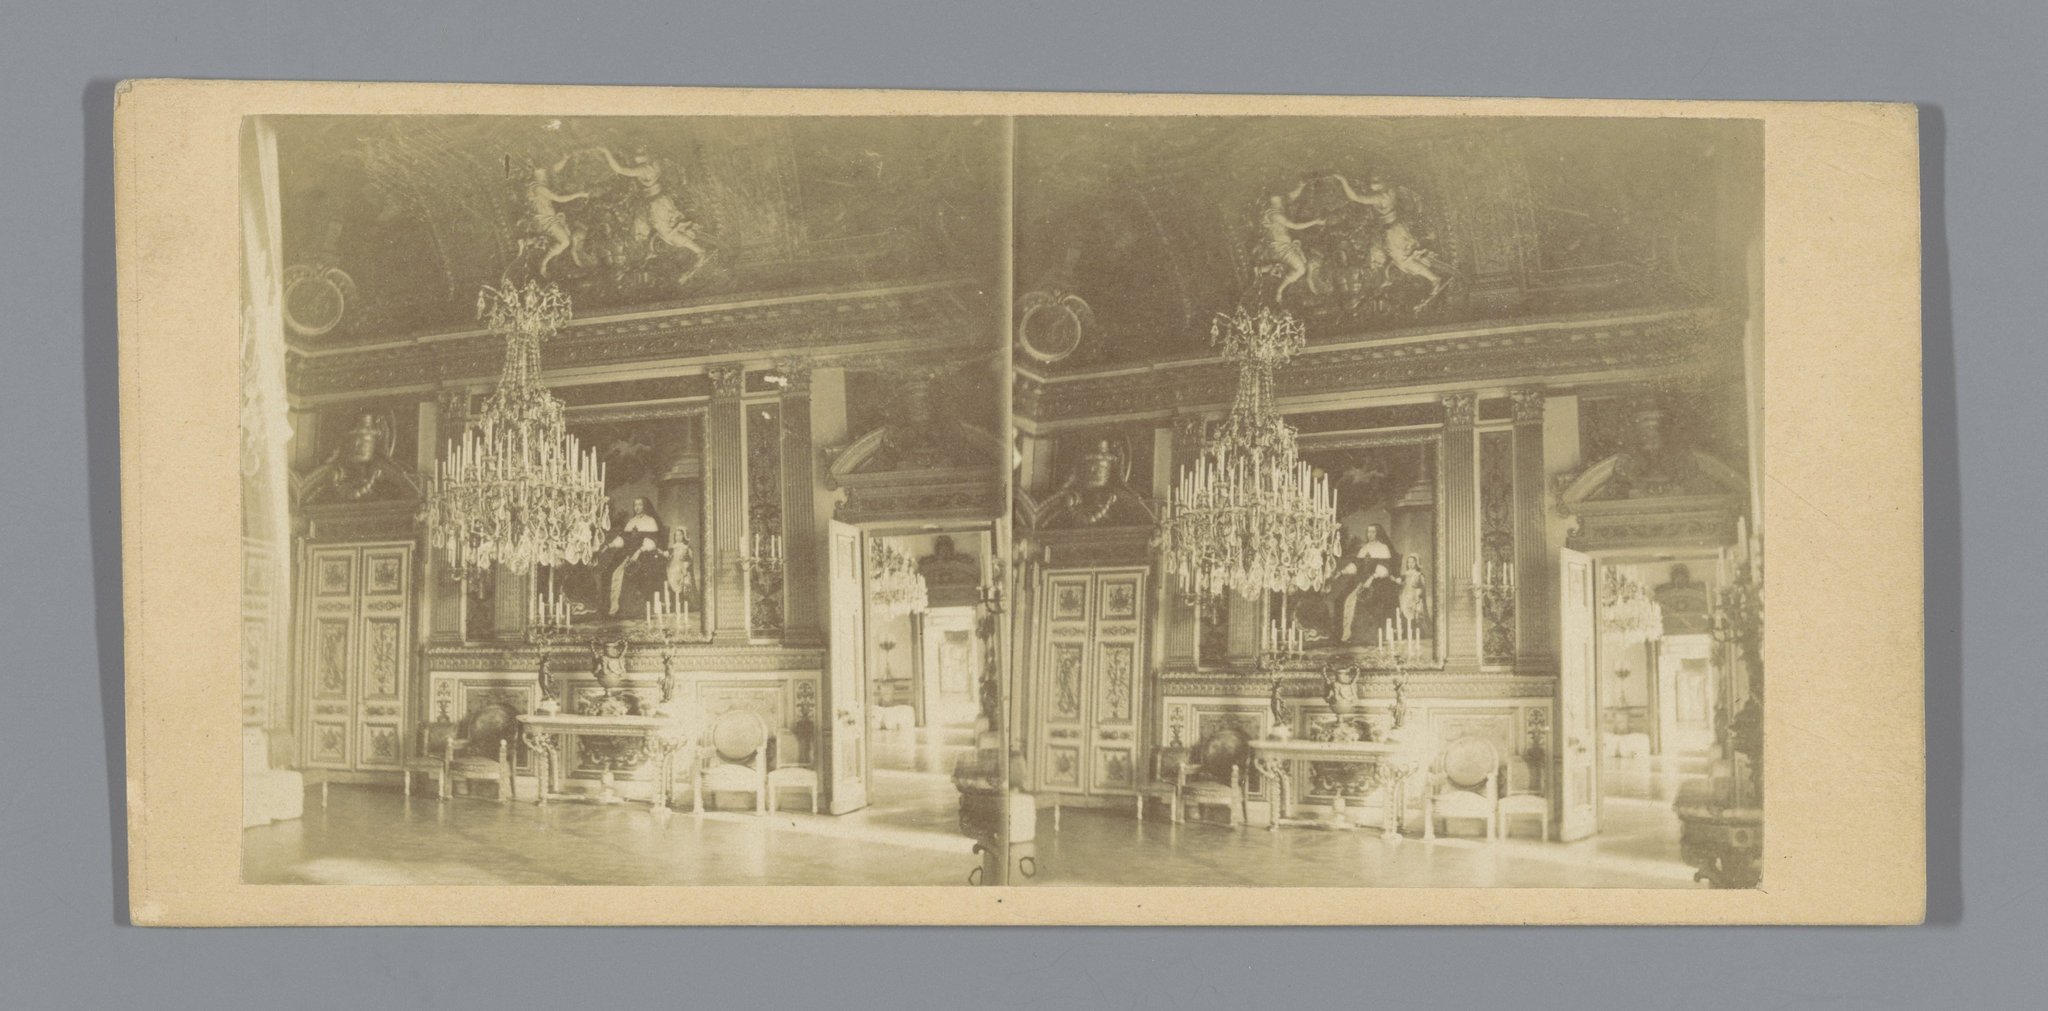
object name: stereograph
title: Interieur van de Salle des Maréchaux in het Palais des Tuileries te Parijs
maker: Anonymous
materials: cardboard, photographic support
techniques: albumen print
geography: tuileries palace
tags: chandelier, candelabrum, interior ~ representation of a building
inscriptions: inscription: ‘salon d'anne d'autriche [...]’